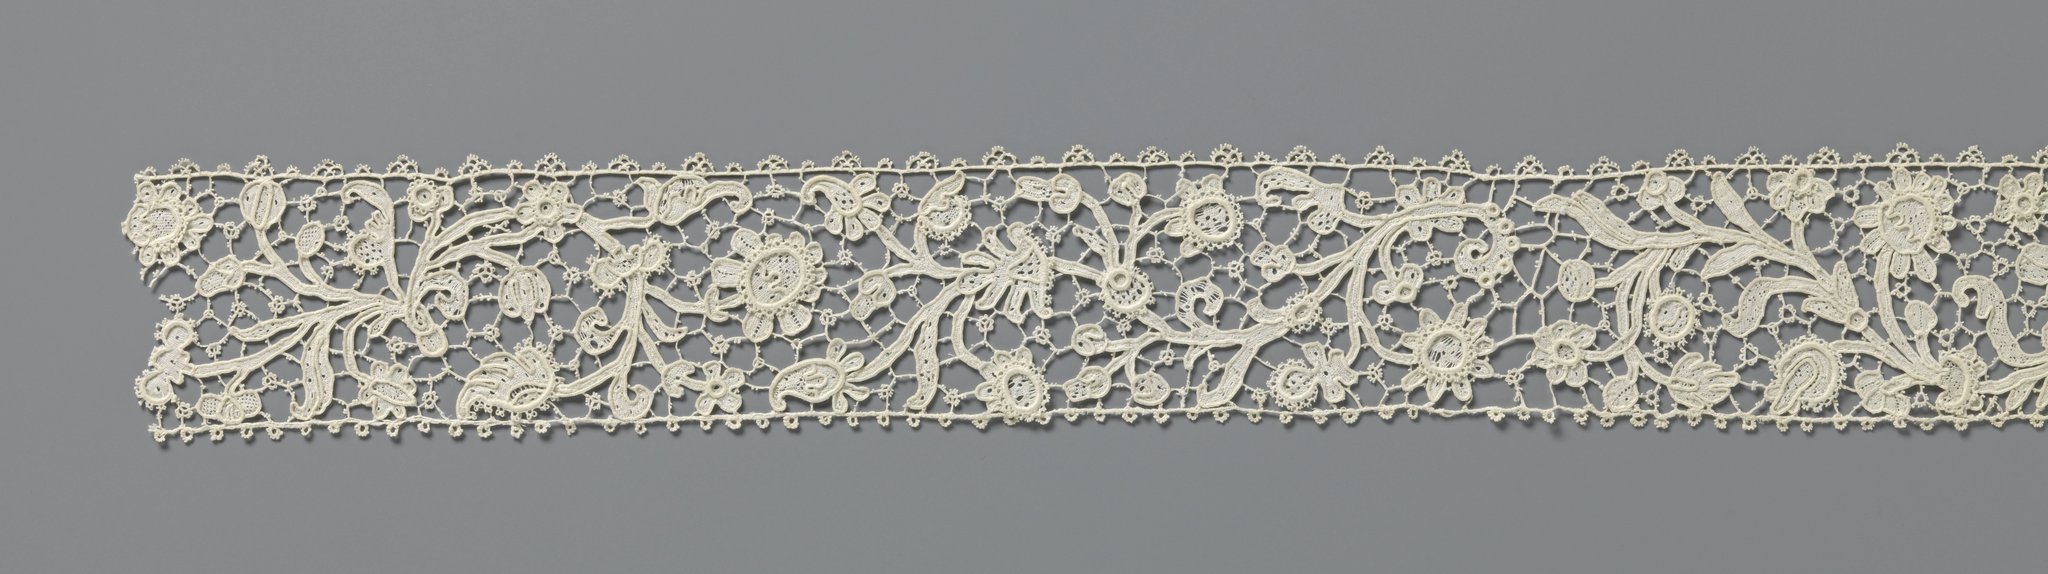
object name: strip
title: Strook naaldkant met drie verschillende bloemenranken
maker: Anonymous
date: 1875-1899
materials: linen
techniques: rose point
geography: burano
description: Strook naturelkleurig naaldkant: Venetiaanse rozenkant. Patroon met een repetitief motief van vier verschillende voluutranken, die over de volle breedte van de strook golven. De ranken raken elkaar niet, maar ze zijn met elkaar verbonden door de onregelmatige grond met gepicoteerde spijlen. Aan de ranken bloemen en bladeren met allerlei verschillende vormen en gevuld met een verscheidenheid aan siergronden door uitsparingen in het volwerk. De bovenzijde is afgezet met een rechte rand met raderpicots. De onderzijde is afgewerkt met een rechte picotrand met boogjes.